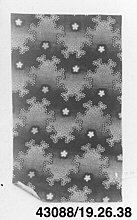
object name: sample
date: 1840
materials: cotton